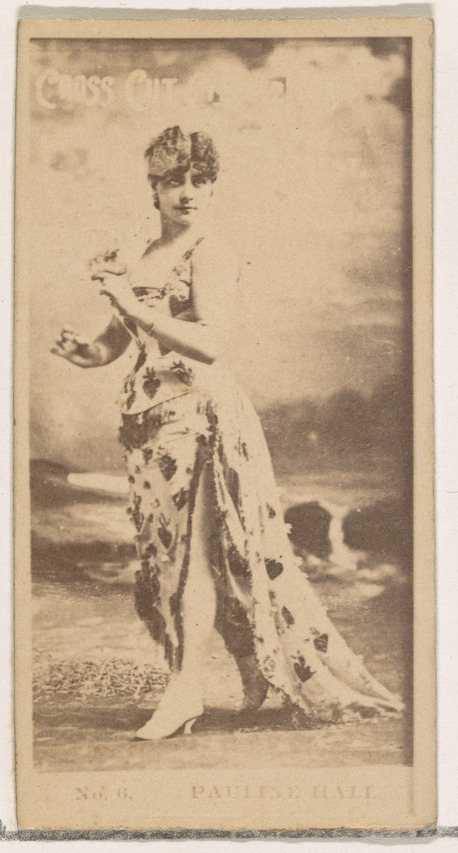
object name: print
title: Card Number 6, Pauline Hall, from the Actors and Actresses series (N145-2) issued by Duke Sons & Co. to promote Cross Cut Cigarettes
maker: w. duke, sons & co.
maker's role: publisher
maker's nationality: american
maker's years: 1870-1920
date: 1880-1889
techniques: albumen silver print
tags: portraits,women,actresses